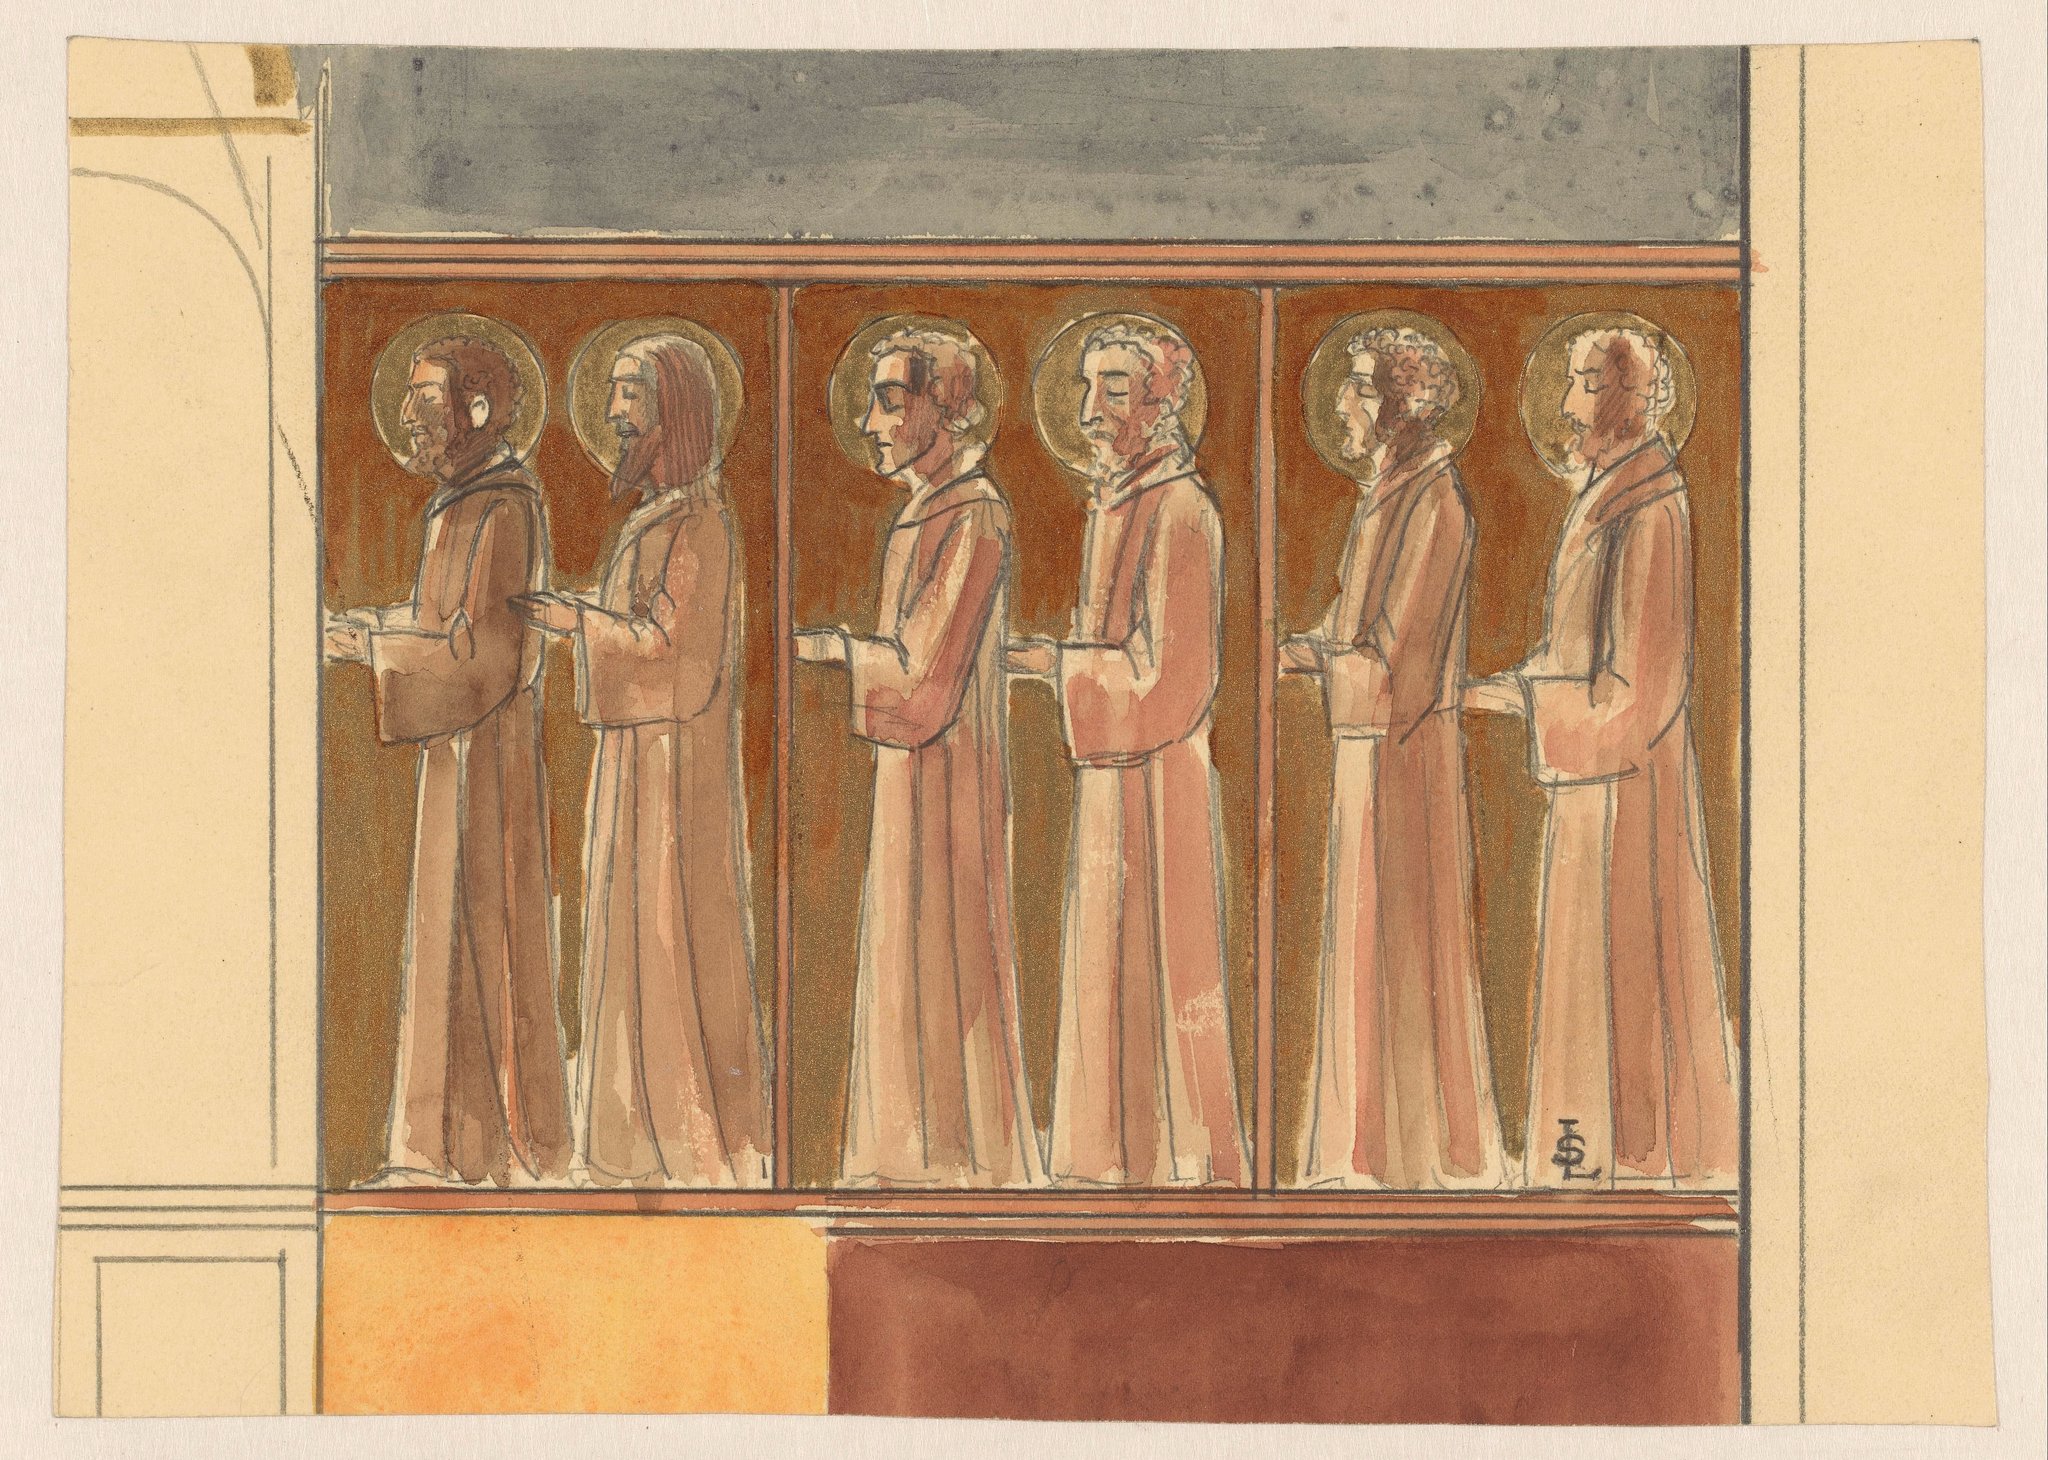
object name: drawing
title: Zes staande biddende heiligen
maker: lodewijk schelfhout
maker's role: draughtsman, print maker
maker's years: 1881-1943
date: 1891-1943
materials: paint, paper, pencil, watercolor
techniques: brush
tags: saints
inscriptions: collector's mark: Lugt 2228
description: Deze tekening is een ontwerp voor het hoogaltaar voor het Heilige Ignatiuscollege in Amsterdam.